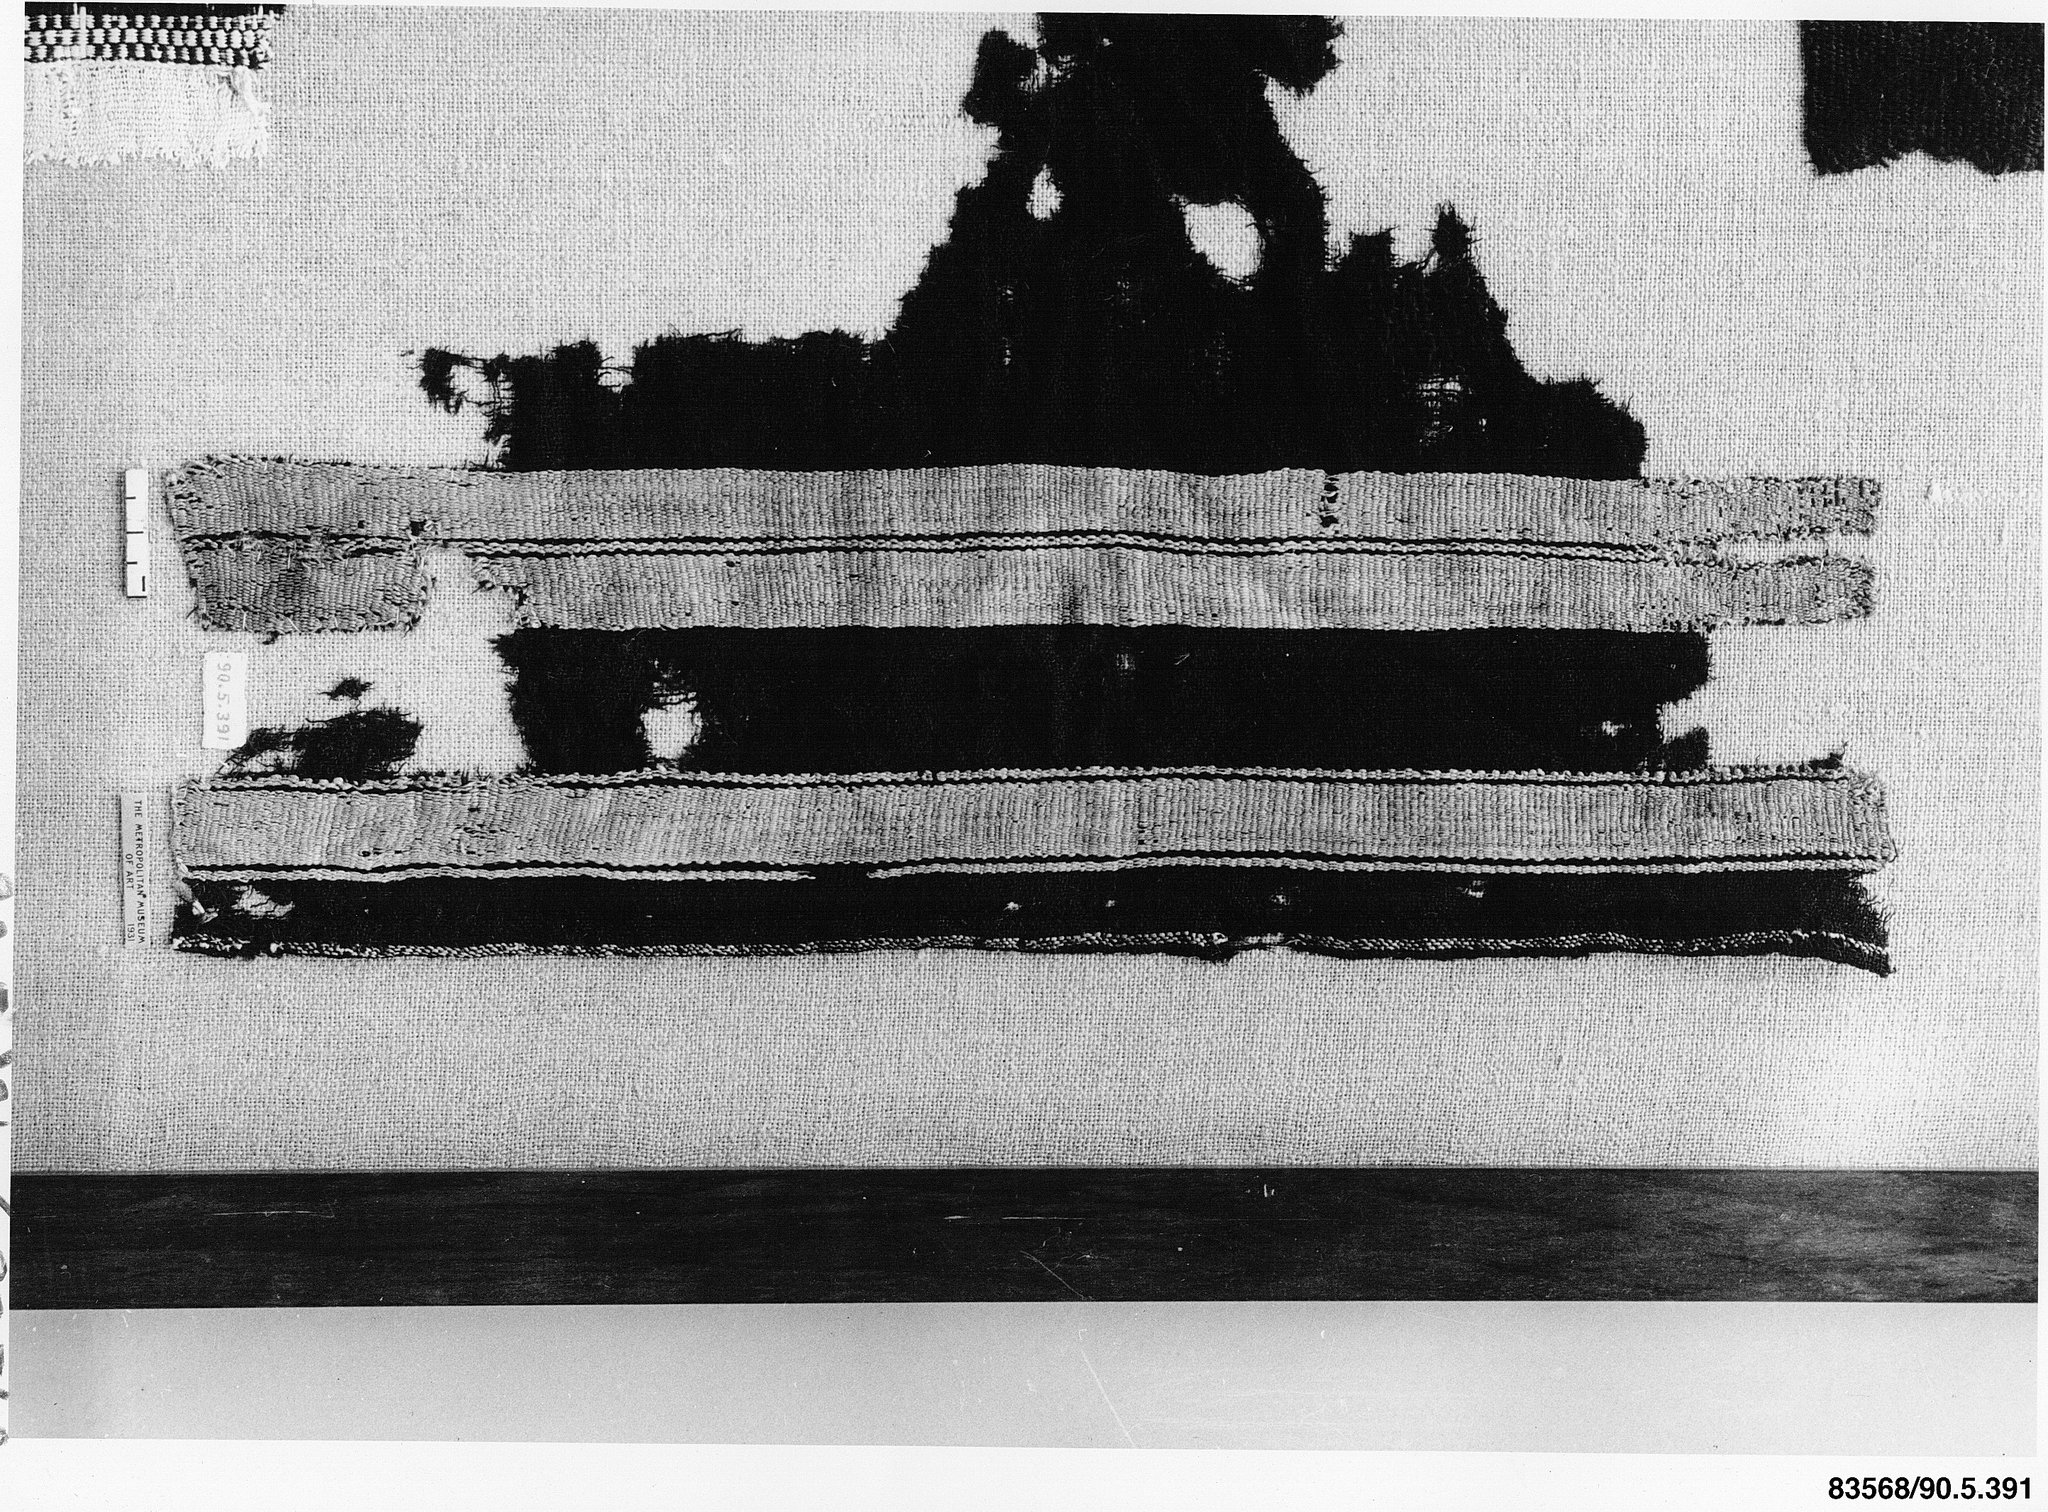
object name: textile fragment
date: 301-500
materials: linen, wool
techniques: weave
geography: egypt